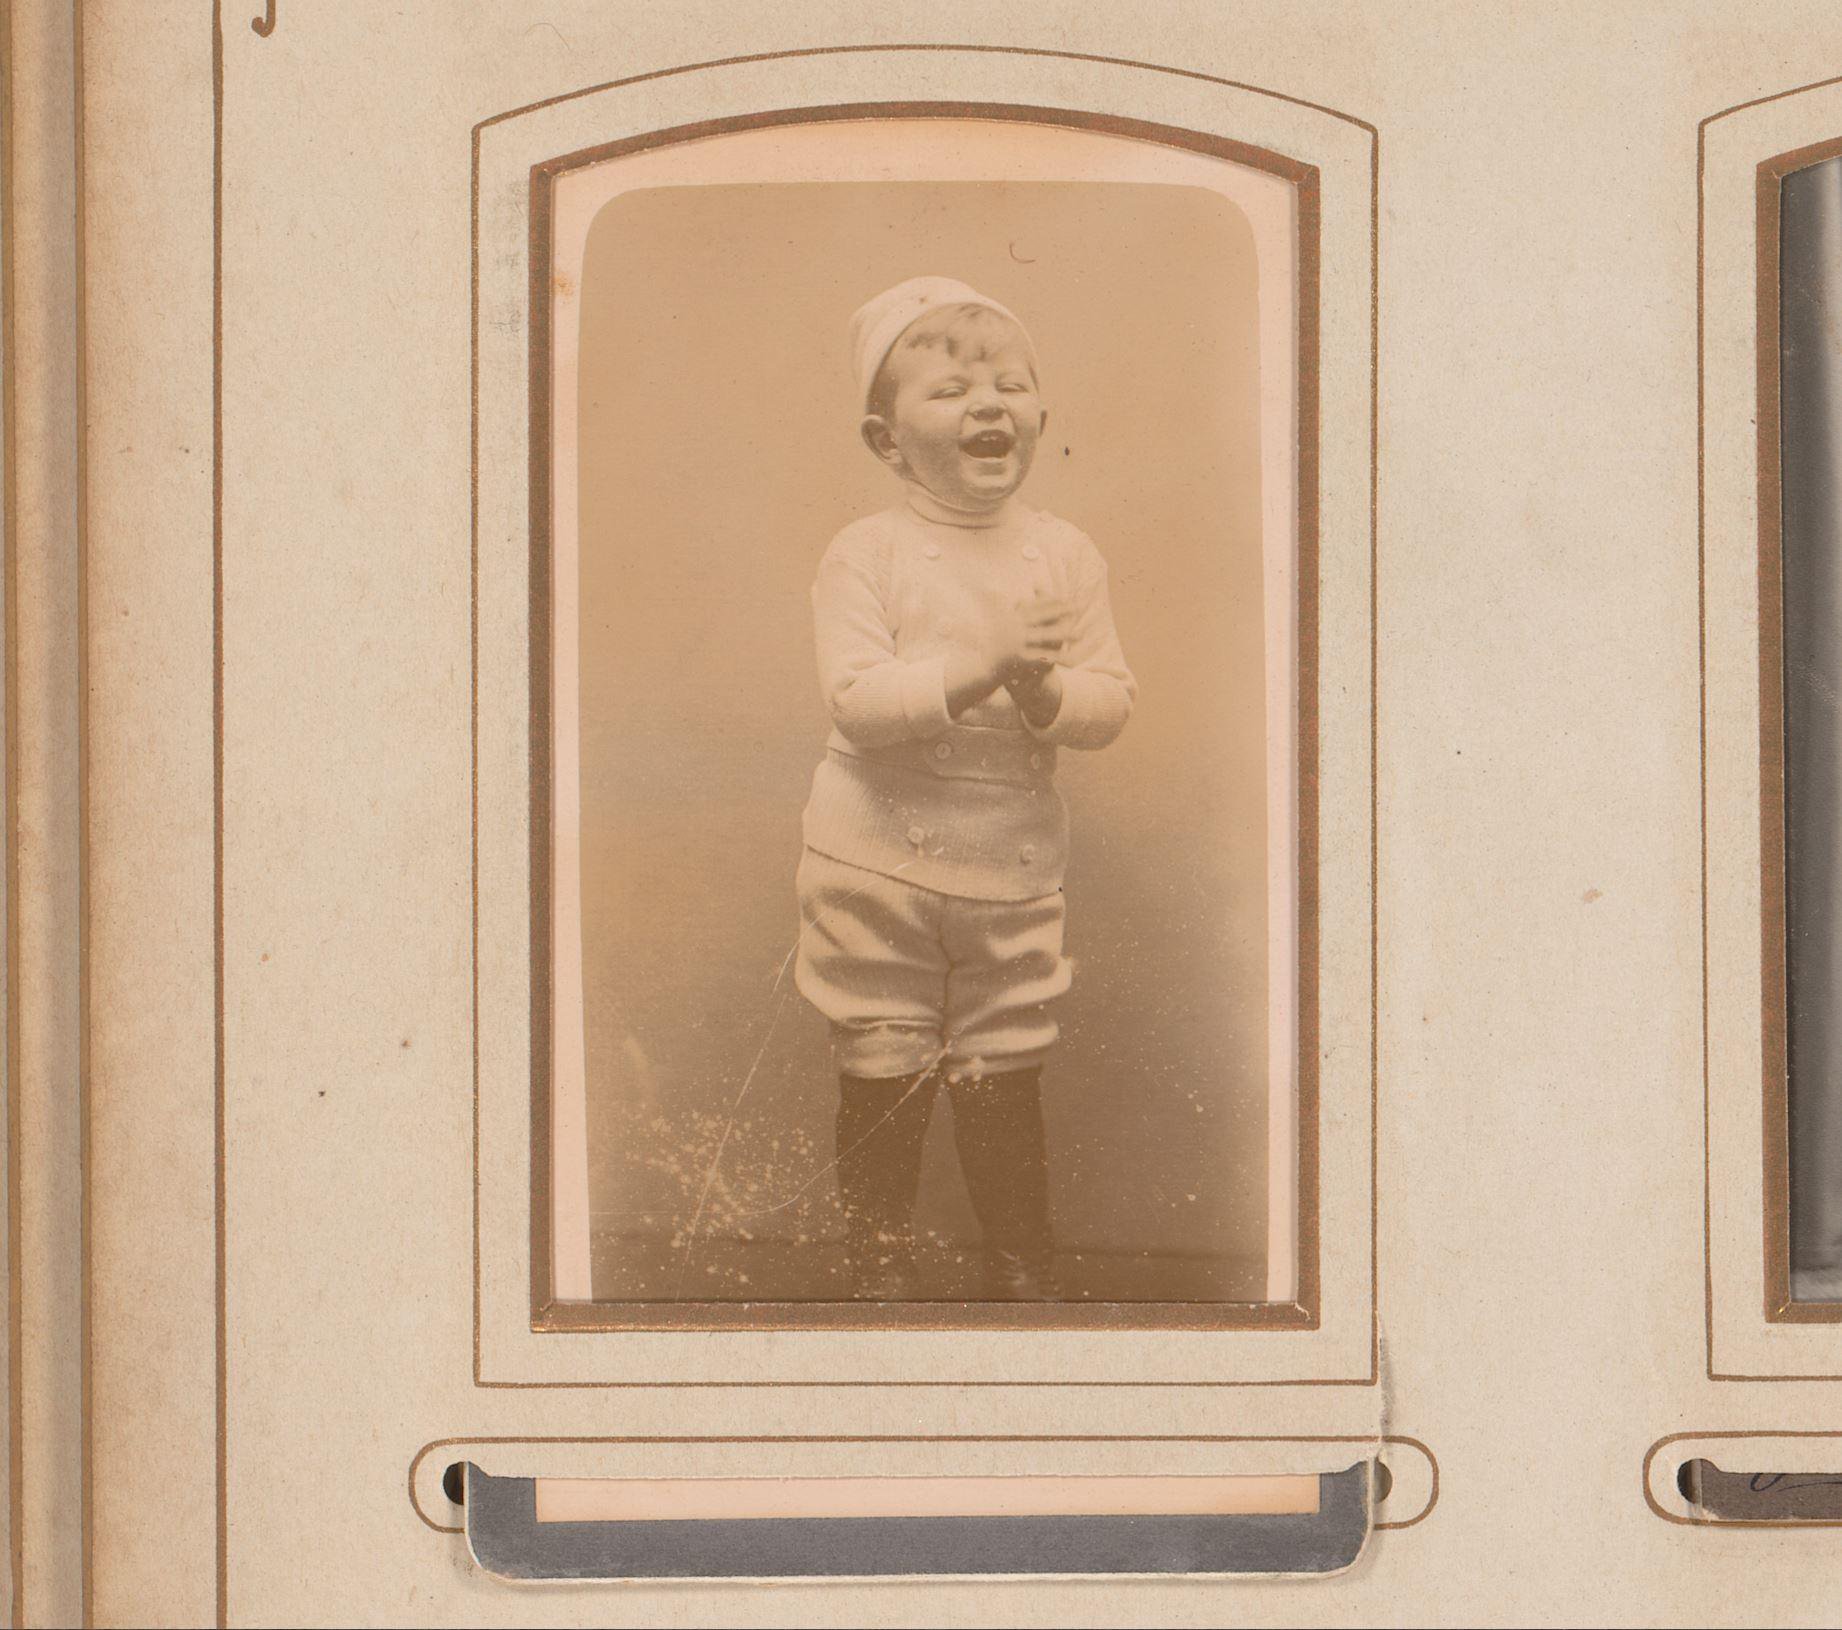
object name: photograph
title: Portret van een lachende jongen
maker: Anonymous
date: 1890-1920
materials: cardboard, photographic support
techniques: gelatin silver print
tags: boy (child between toddler and youth), laughing